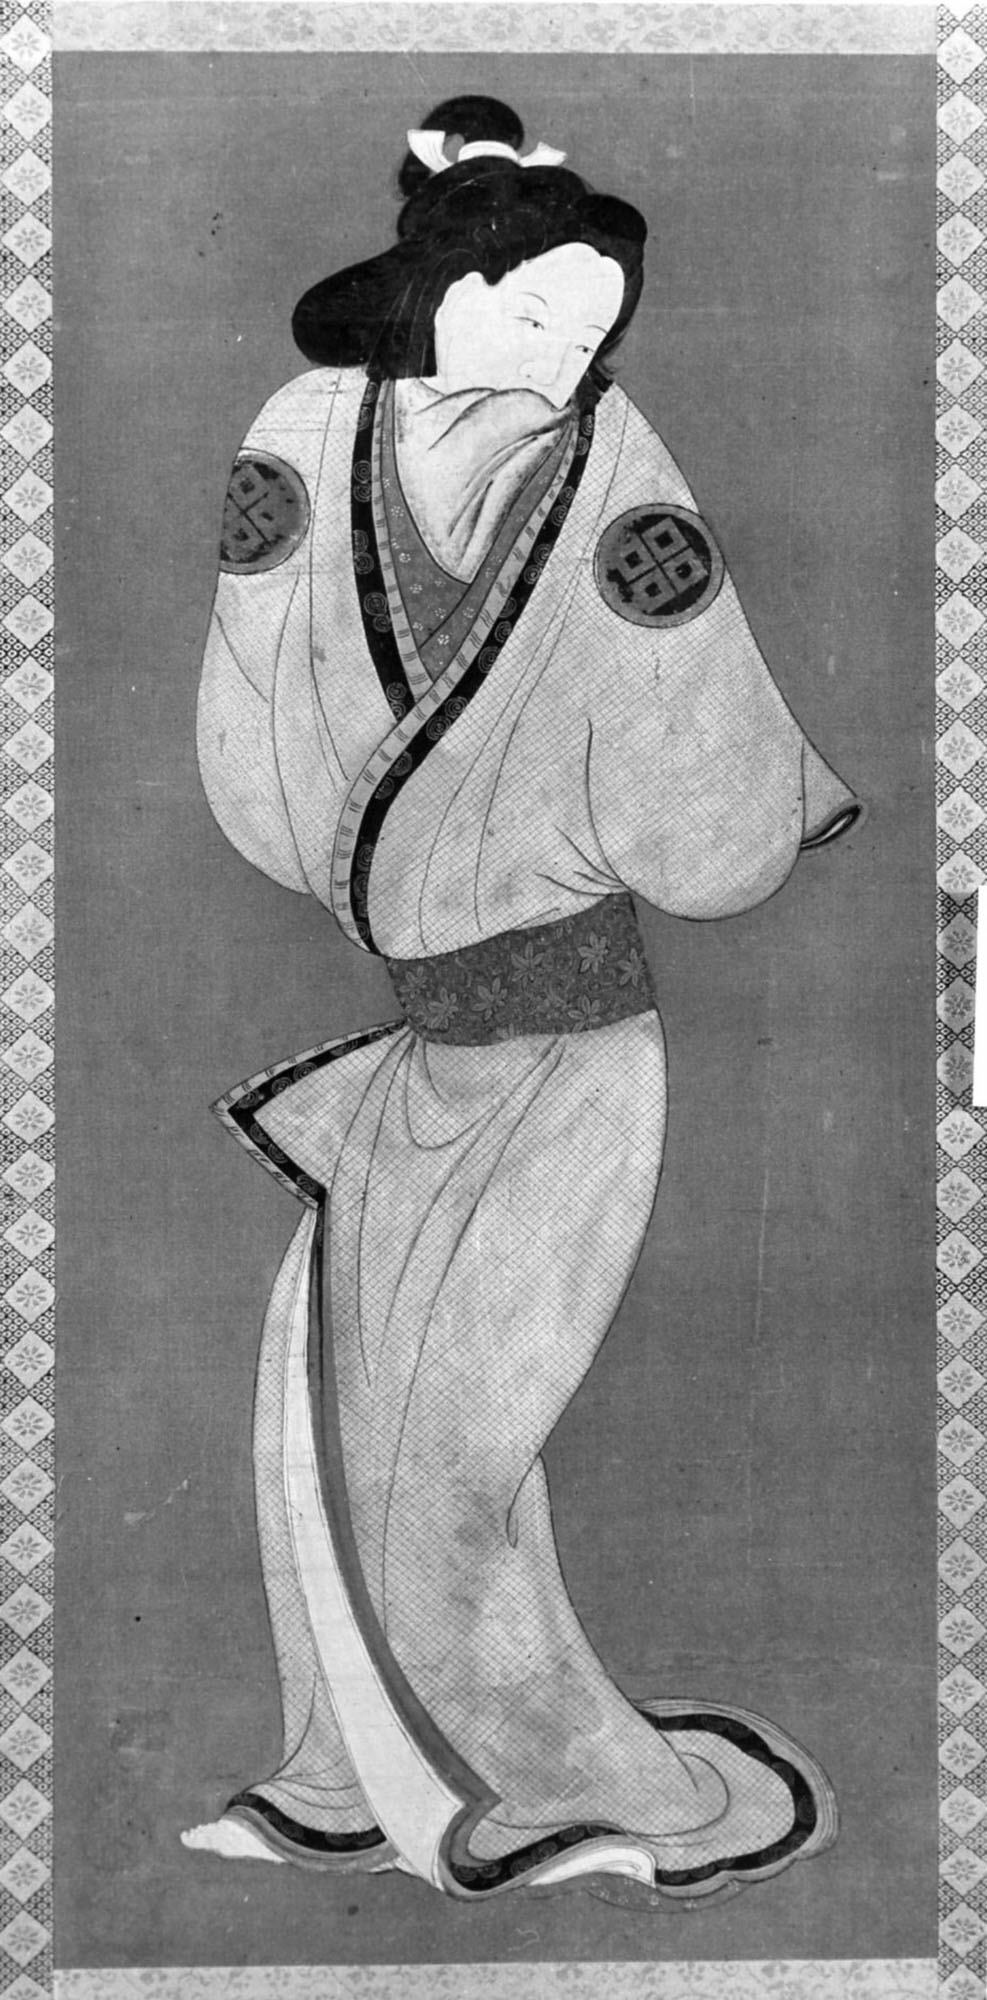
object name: hanging scroll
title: Beauty of the Kanbun Era (Kanbun Bijin)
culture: japanese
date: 1667-1700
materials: silk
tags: women